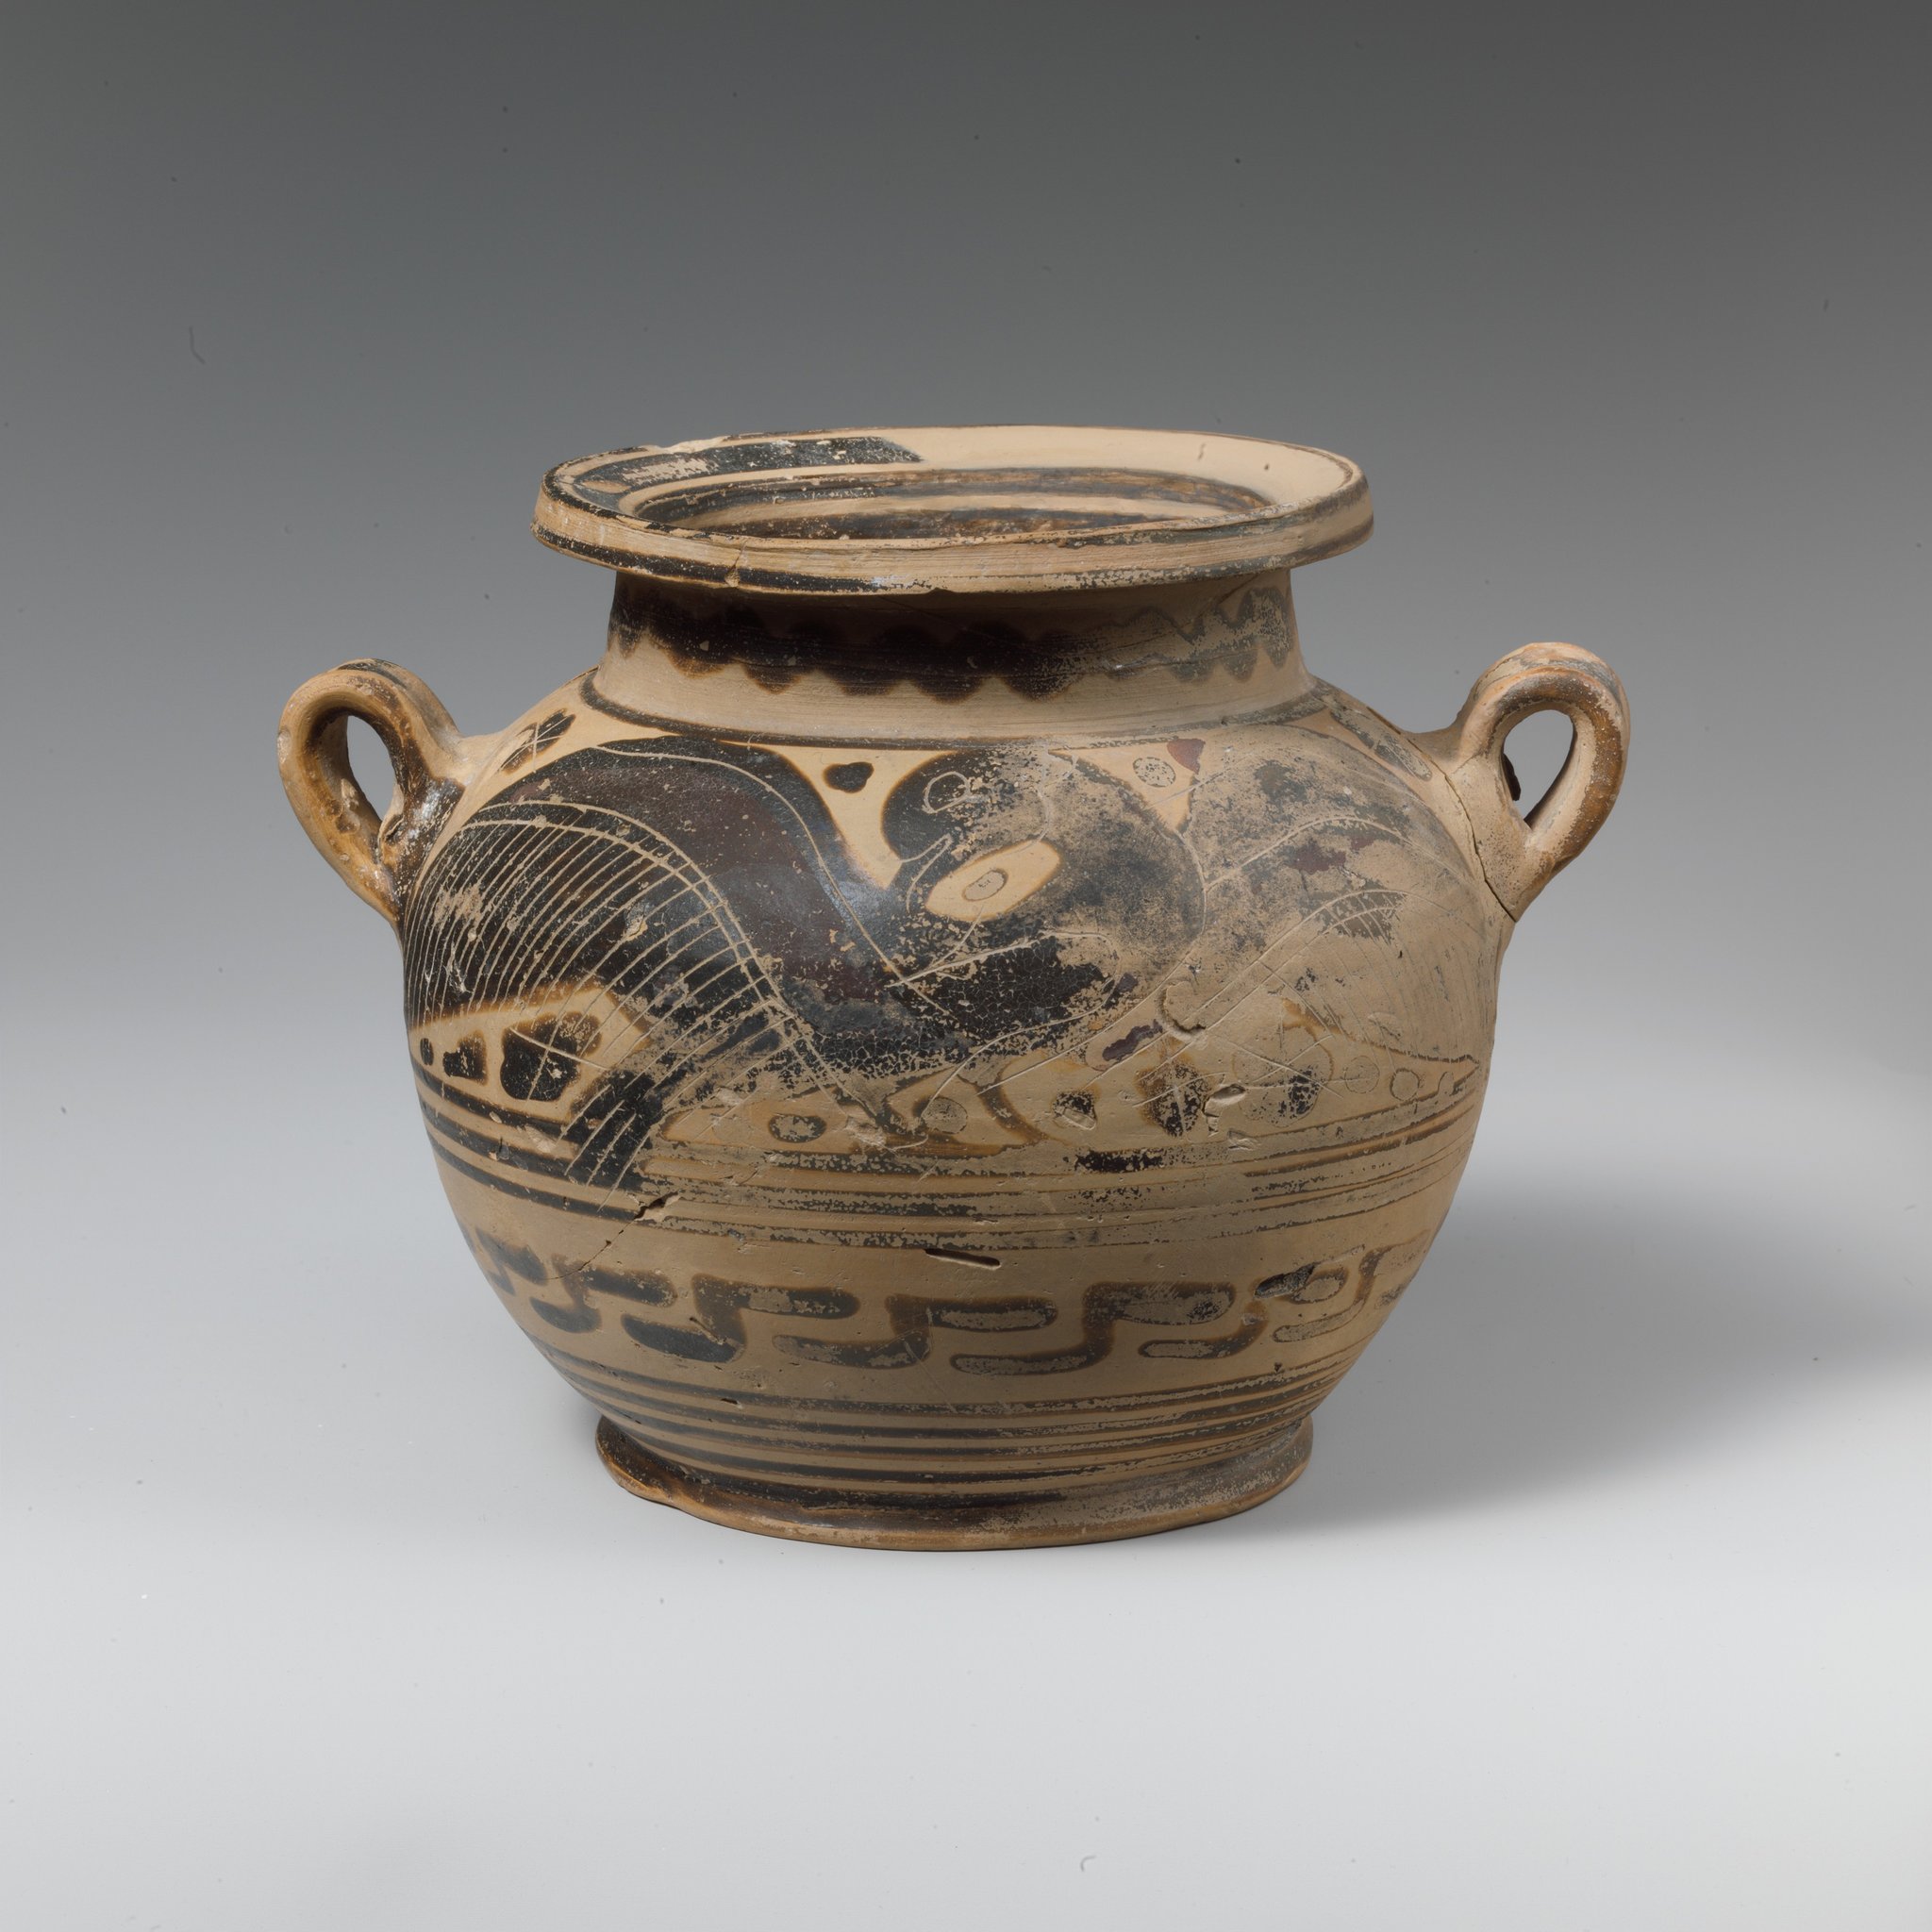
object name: pyxis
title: Terracotta pyxis (box)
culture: greek, corinthian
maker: hermitage painter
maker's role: artist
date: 590-570 BCE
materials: terracotta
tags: eagles